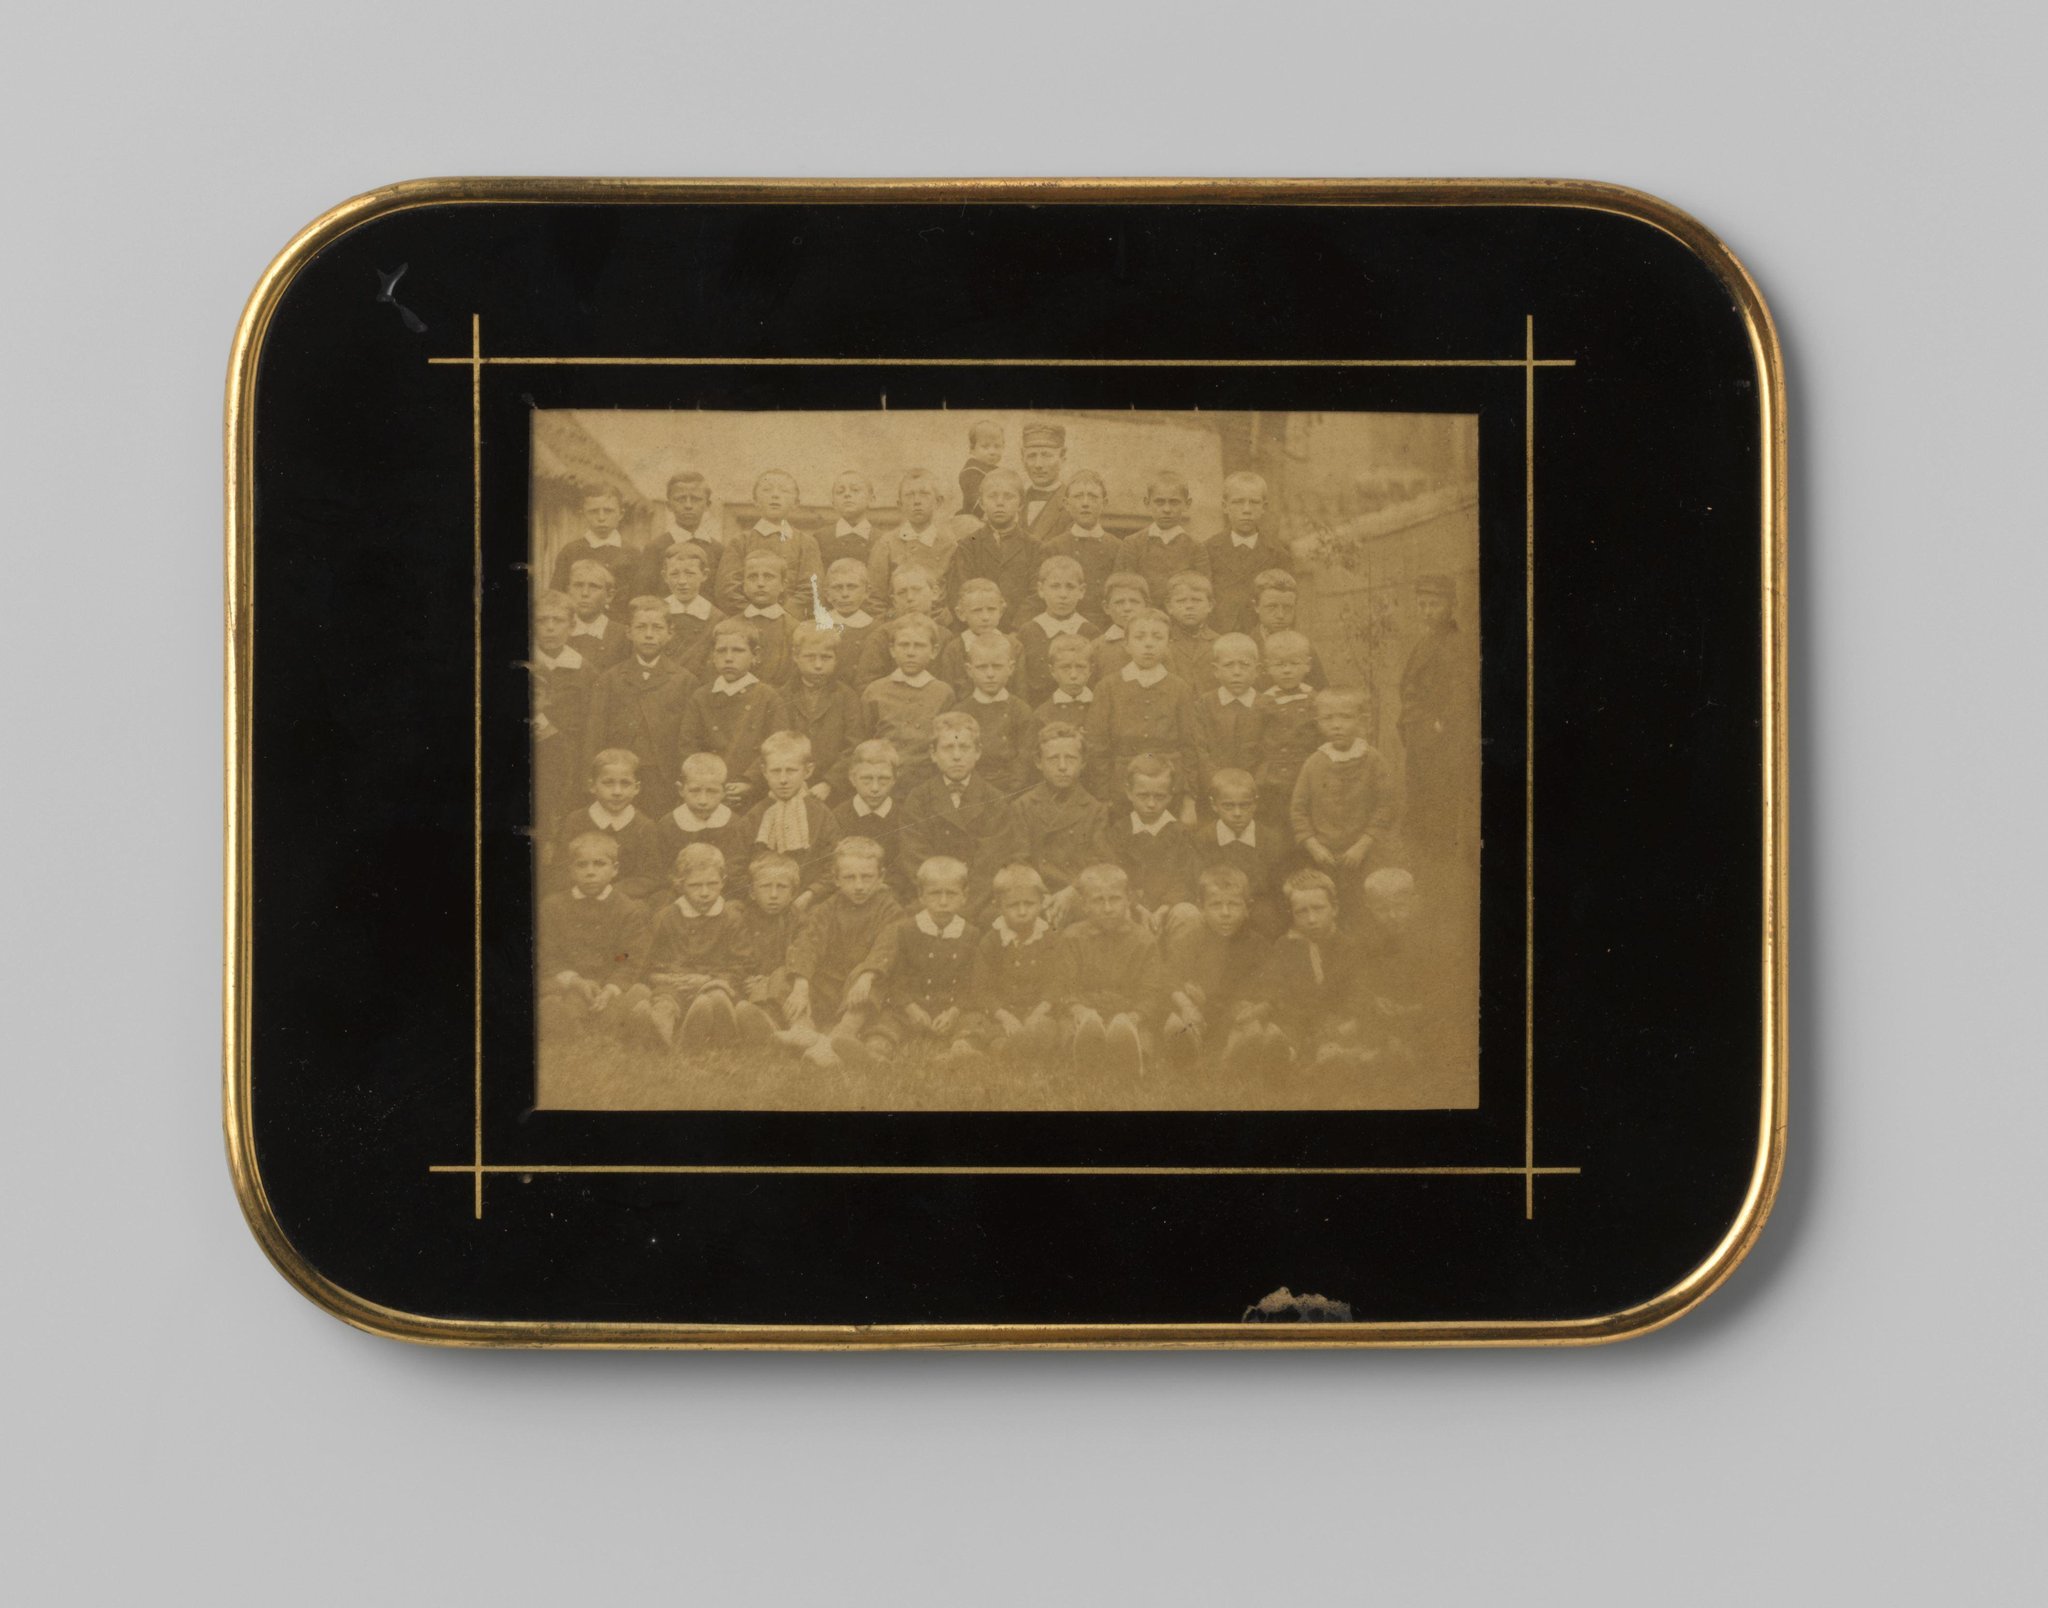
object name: frame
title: Groepsportret van een schoolklas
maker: Anonymous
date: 1880-1900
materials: cardboard, glass, metal, paper, wood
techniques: albumen print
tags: elementary school; class, form